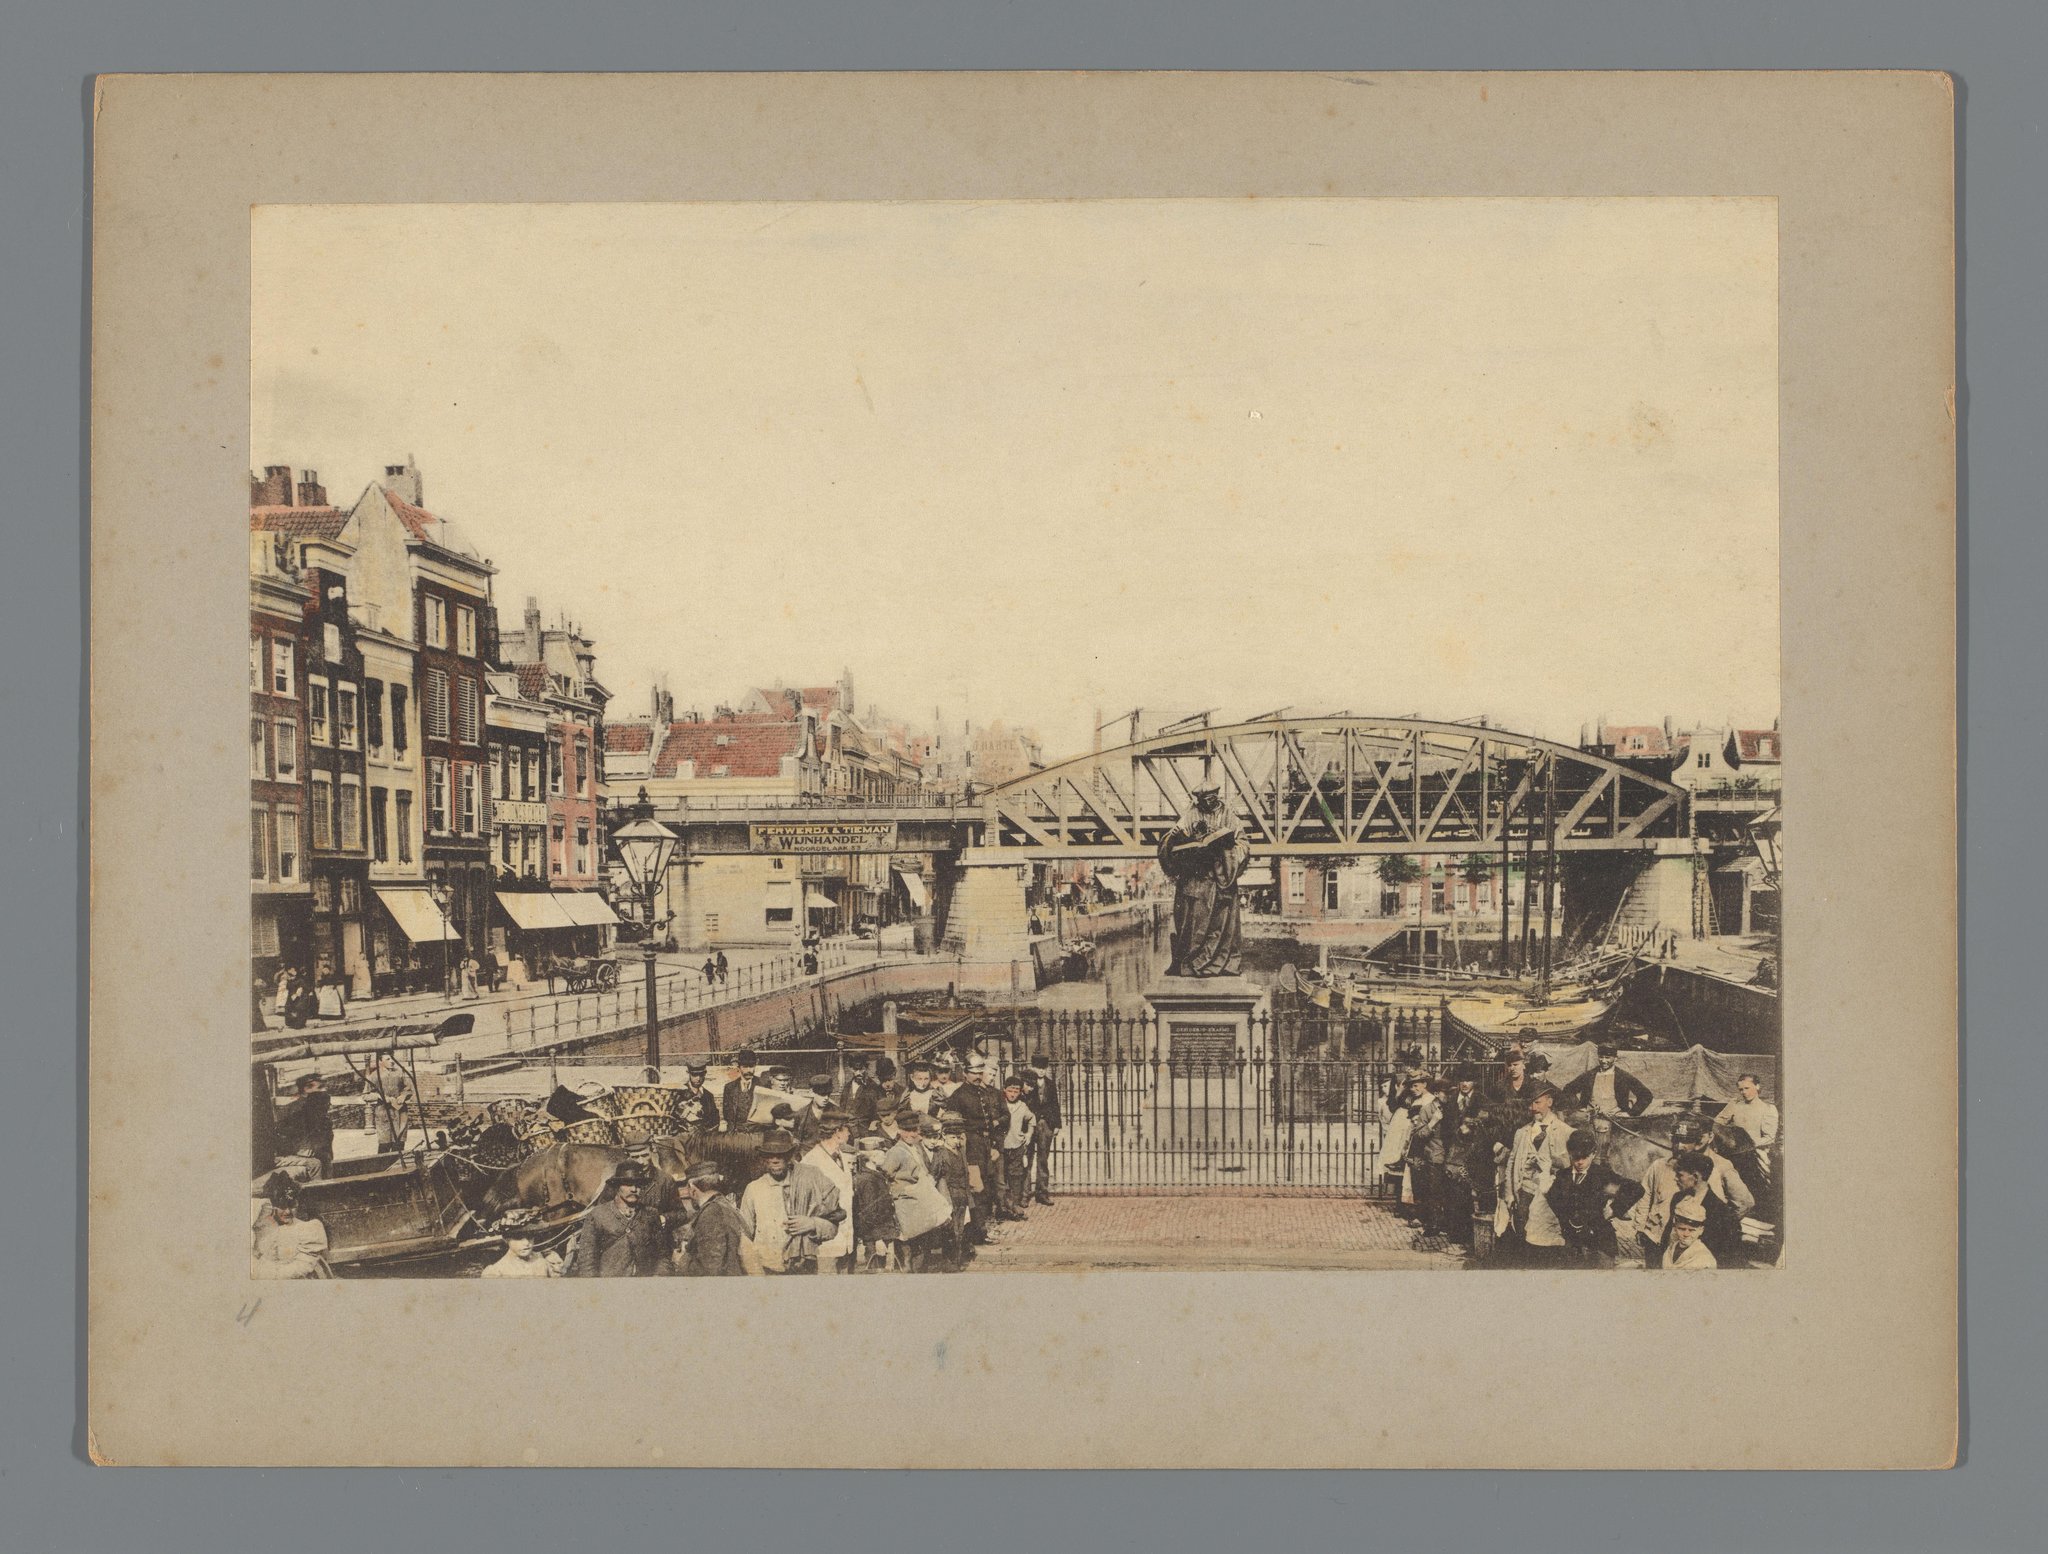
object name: photomechanical print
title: Rotterdam - Statue d'Erasme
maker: Anonymous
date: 1883-1910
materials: cardboard, paper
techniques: photograph, hand coloring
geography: rotterdam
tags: rotterdam, desiderius erasmus, monument, statue, bridge